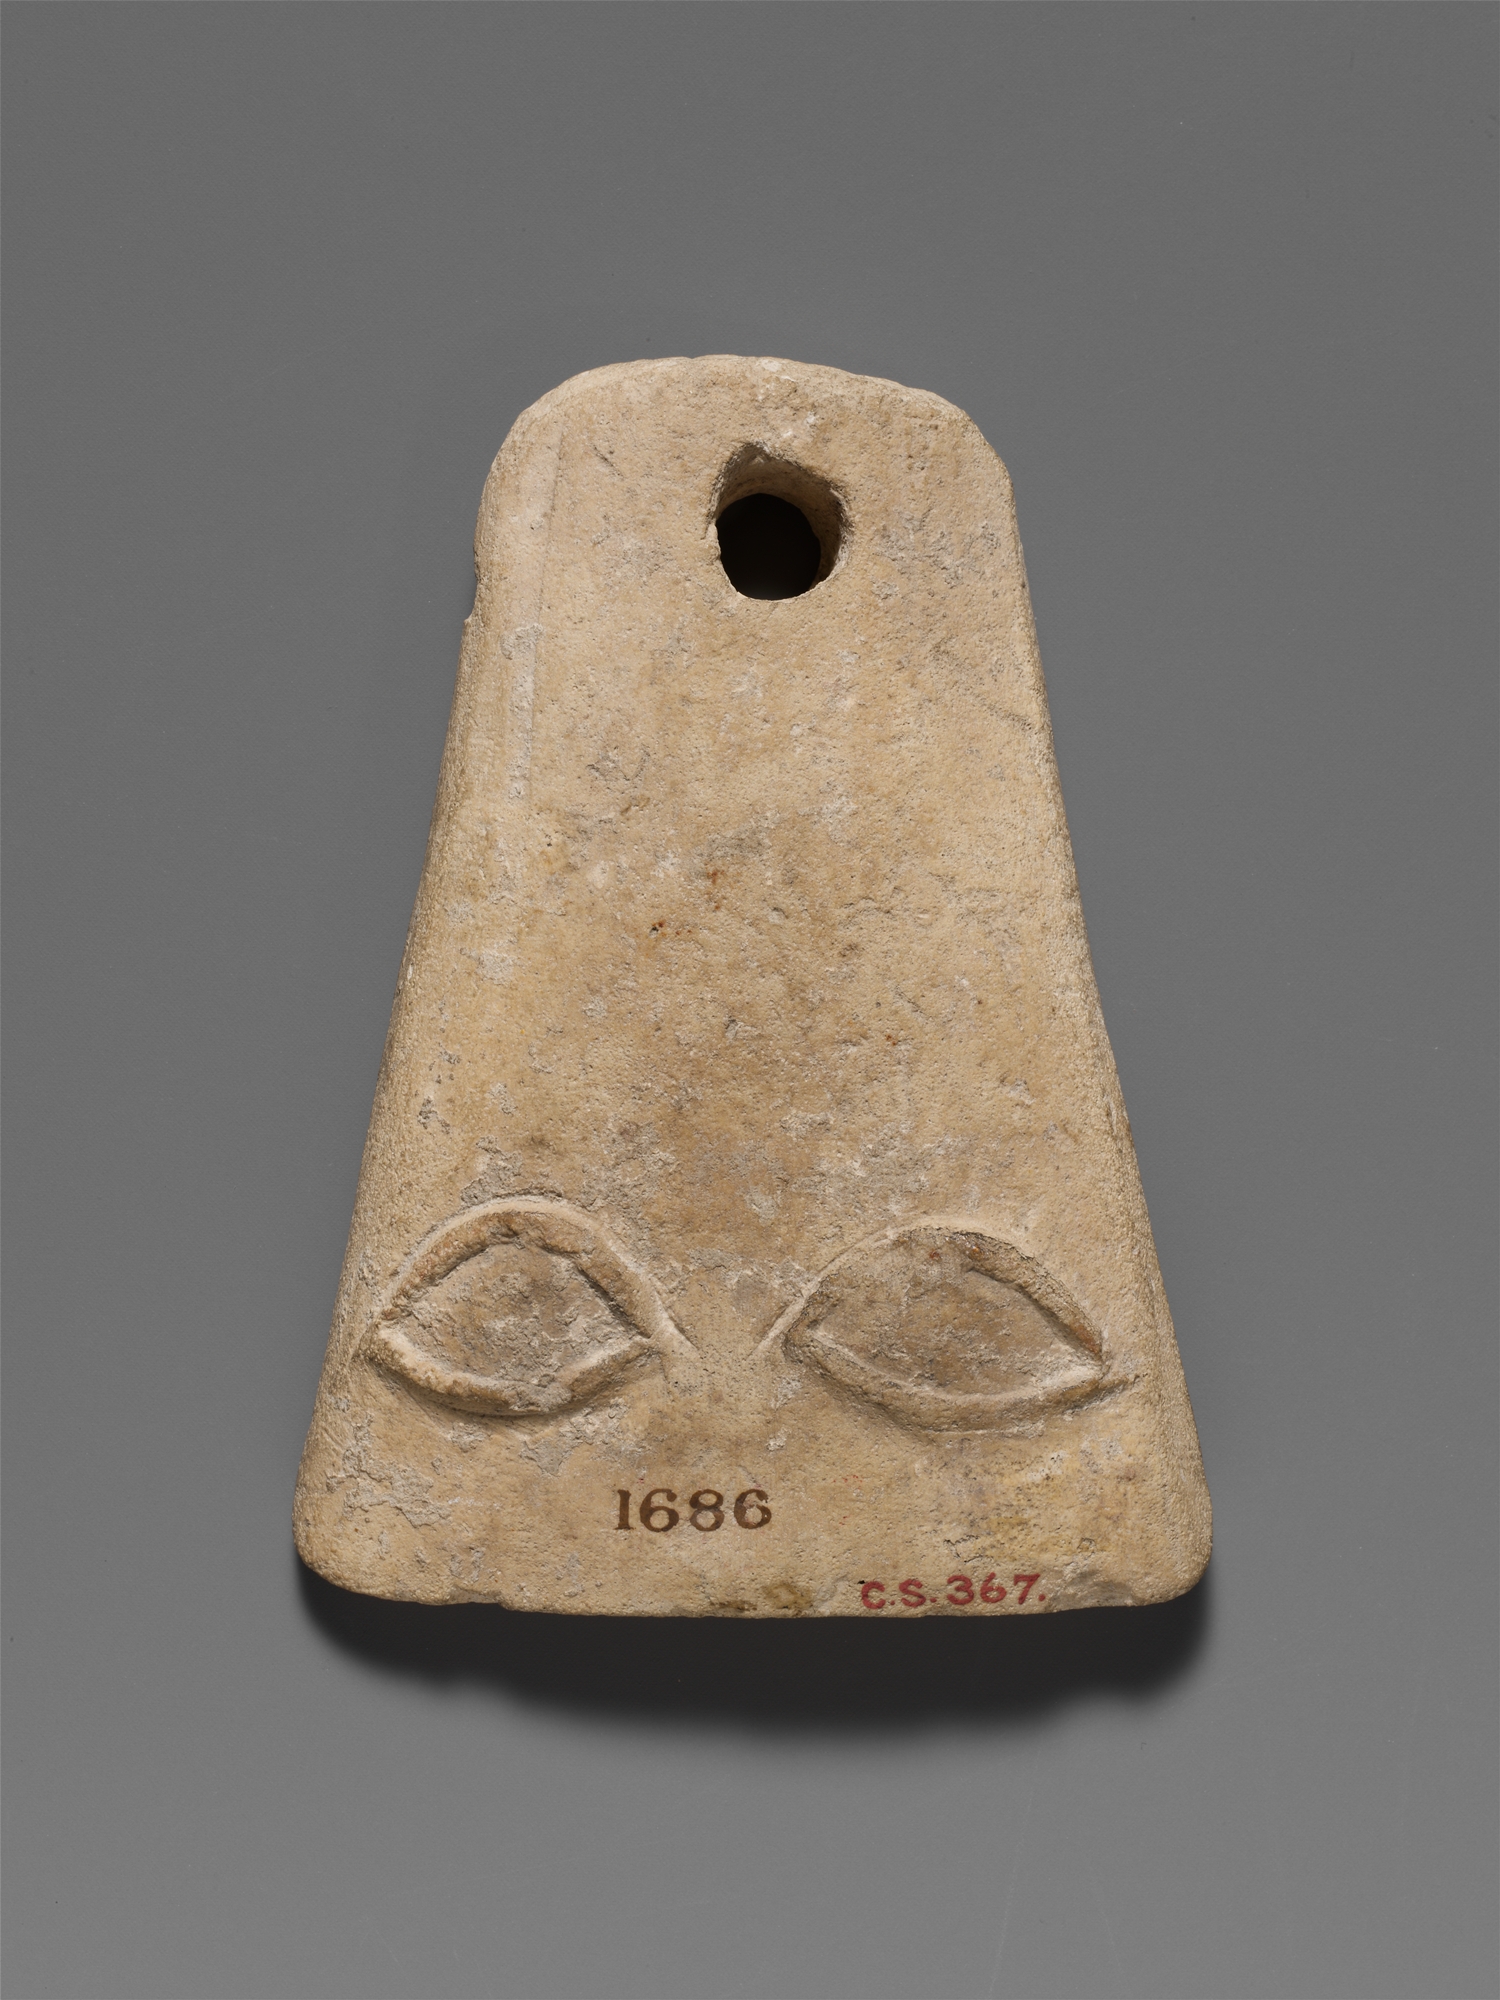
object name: eye, votive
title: Limestone plaque with two eyes in relief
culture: greek or roman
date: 50 BCE-50 CE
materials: limestone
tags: eyes